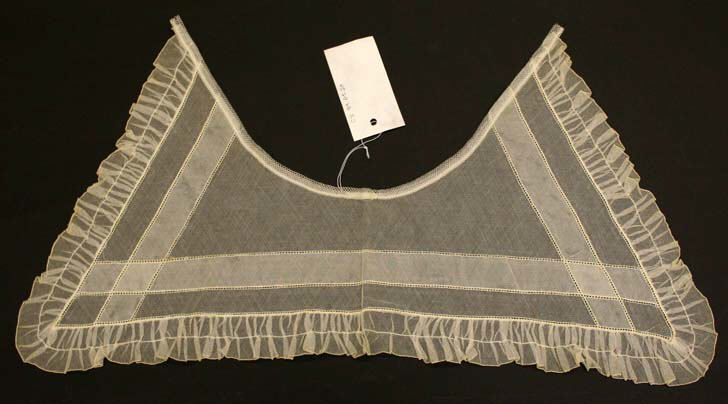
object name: collar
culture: american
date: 1700-1939